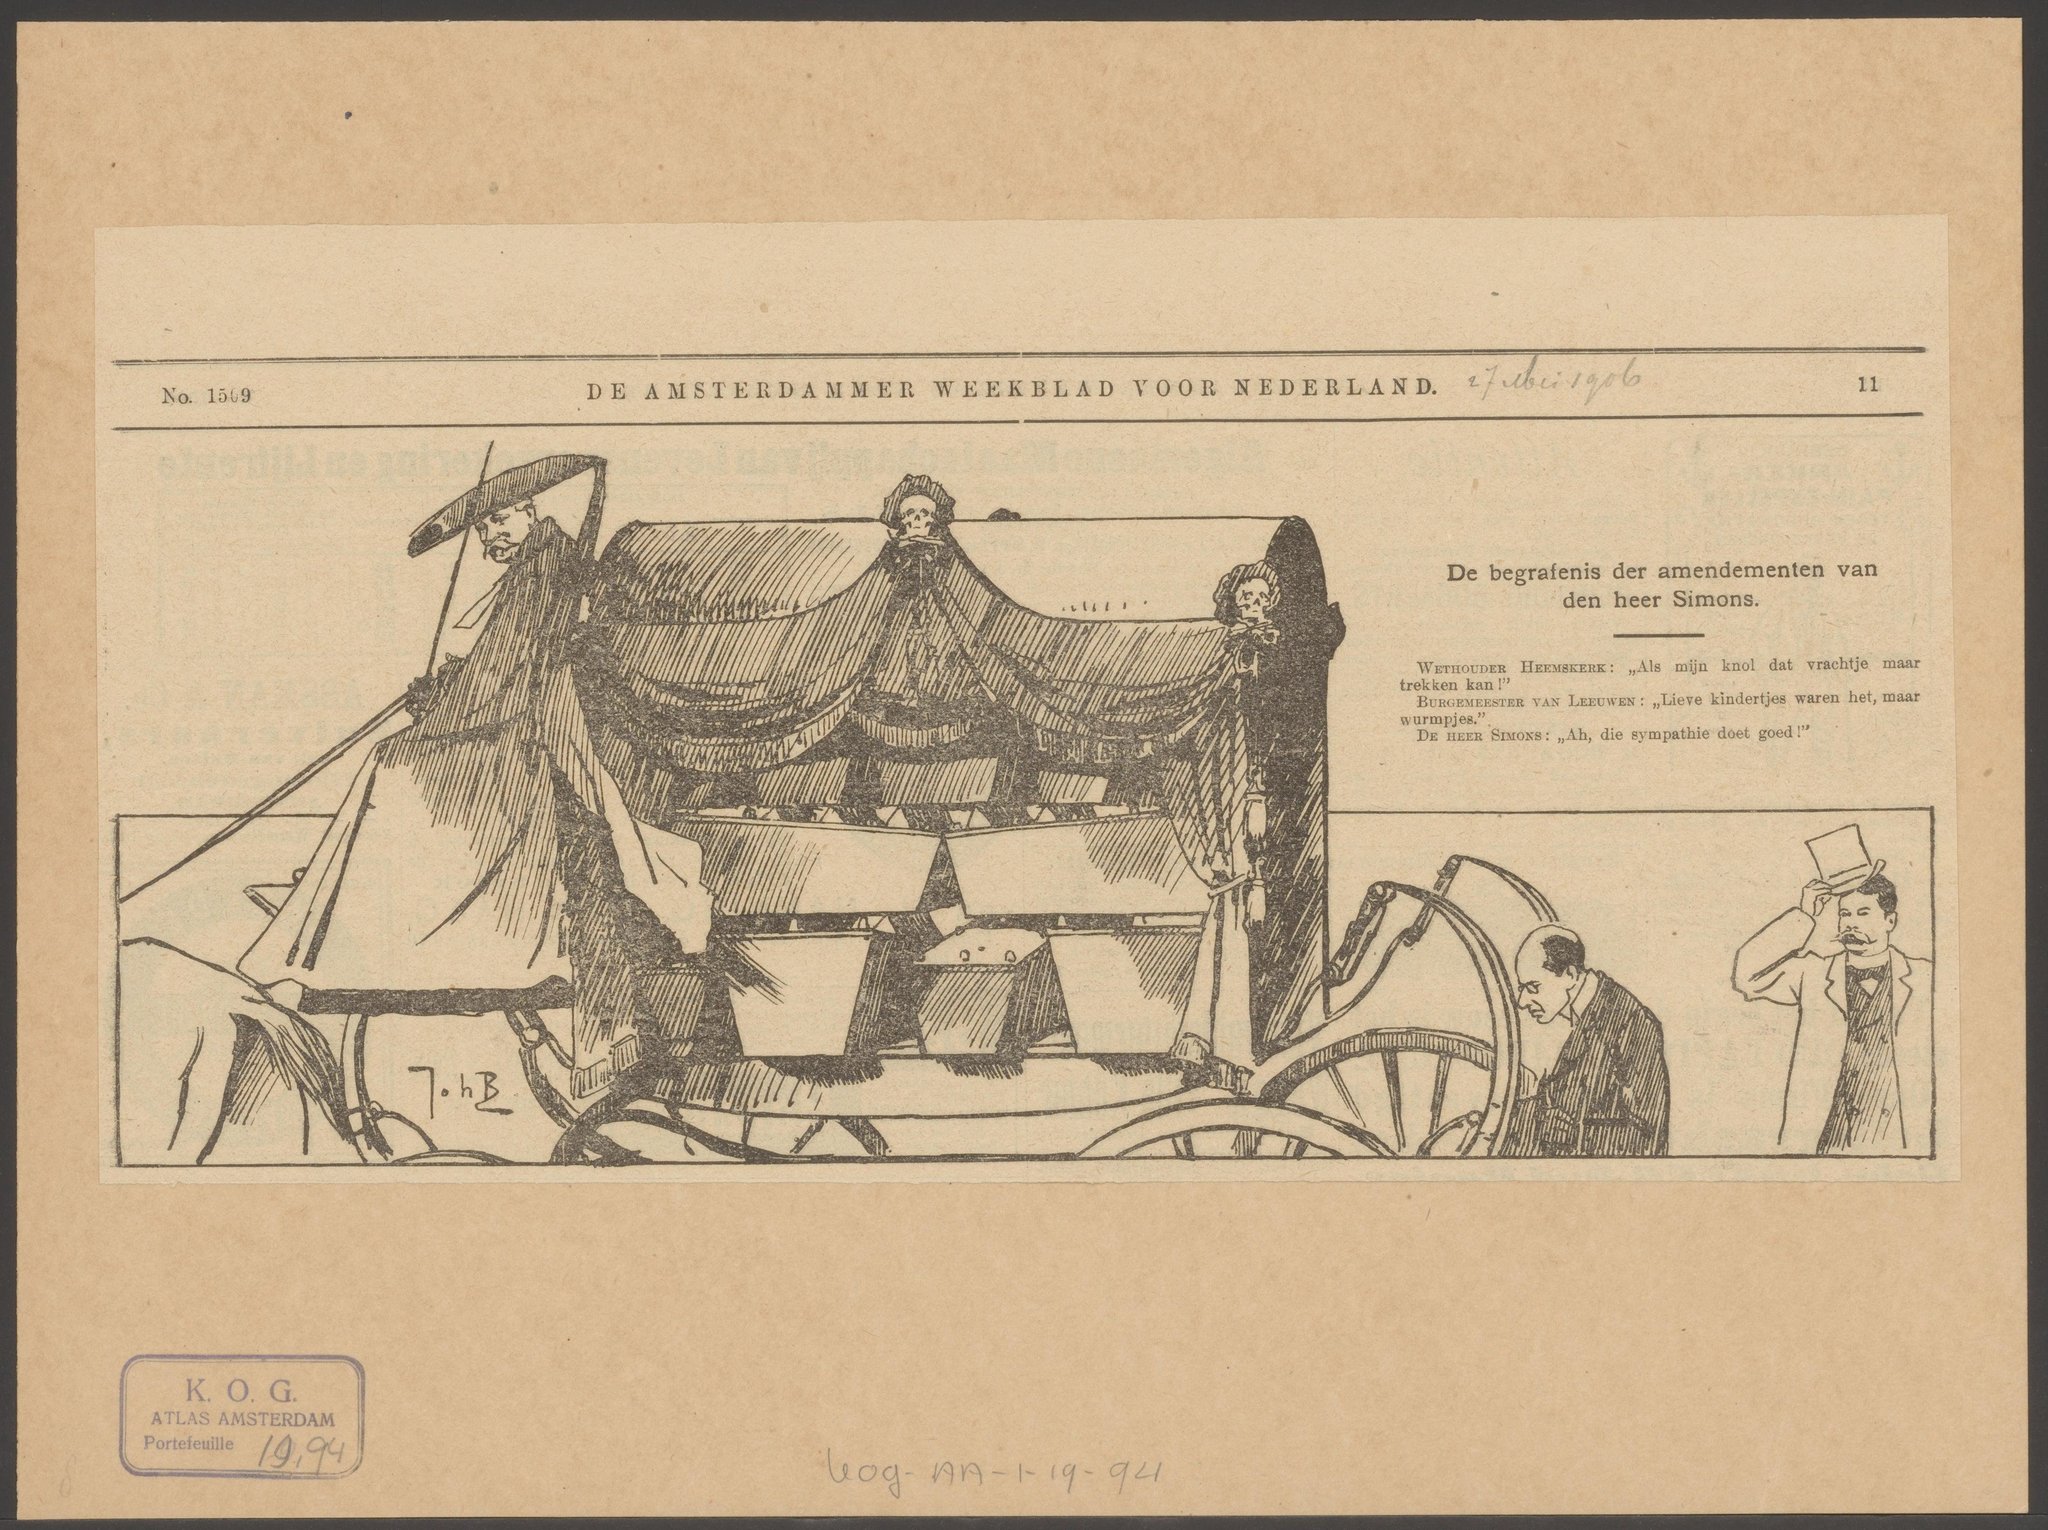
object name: cartoon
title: De begrafenis der amendementen van den heer Simons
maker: johan braakensiek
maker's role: draughtsman, print maker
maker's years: 1858-1940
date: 1906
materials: paper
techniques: letterpress printing, line block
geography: amsterdam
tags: hearse, funeral car, political caricatures and satires, amsterdam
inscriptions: collector's mark: ‘19,94’ Lugt 1641b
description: Onderwerpsrubriek binnen de Atlas Amsterdam: Herinneringen aan regeringsleden en hunne huisgezinnen [na 1800].